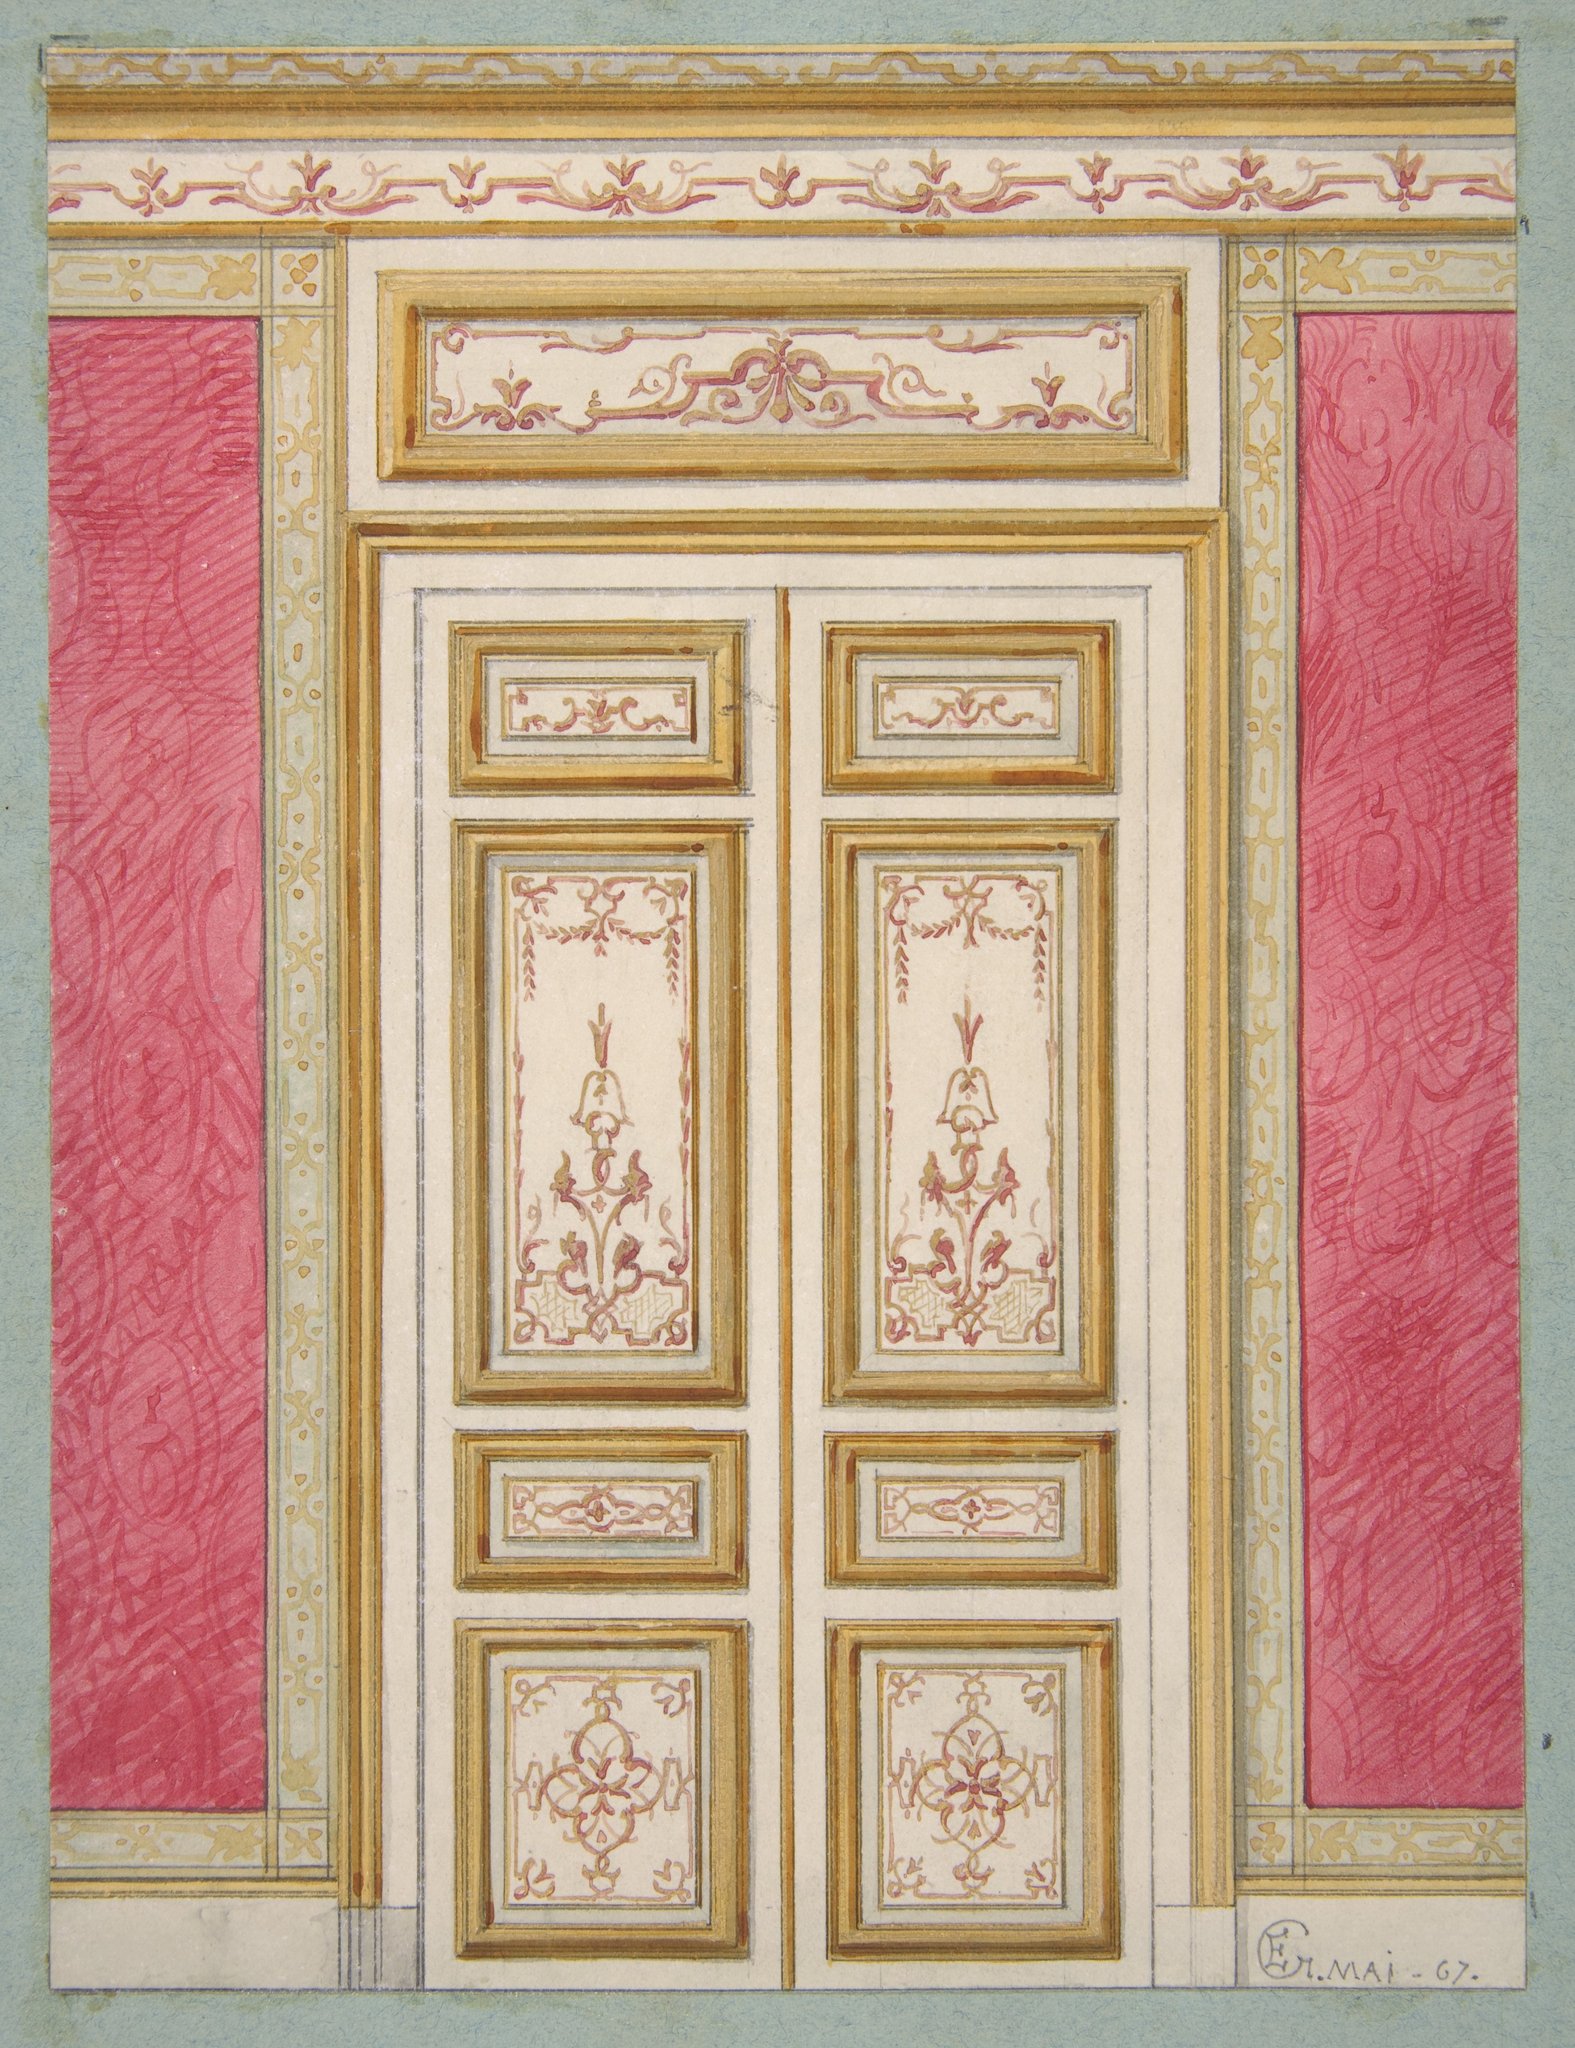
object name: drawing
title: Design for double doors decorated in the rococco style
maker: jules-edmond-charles lachaise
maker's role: artist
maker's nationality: french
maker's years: 1897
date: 1867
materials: gold paint, graphite, ink, paper, watercolor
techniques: pen